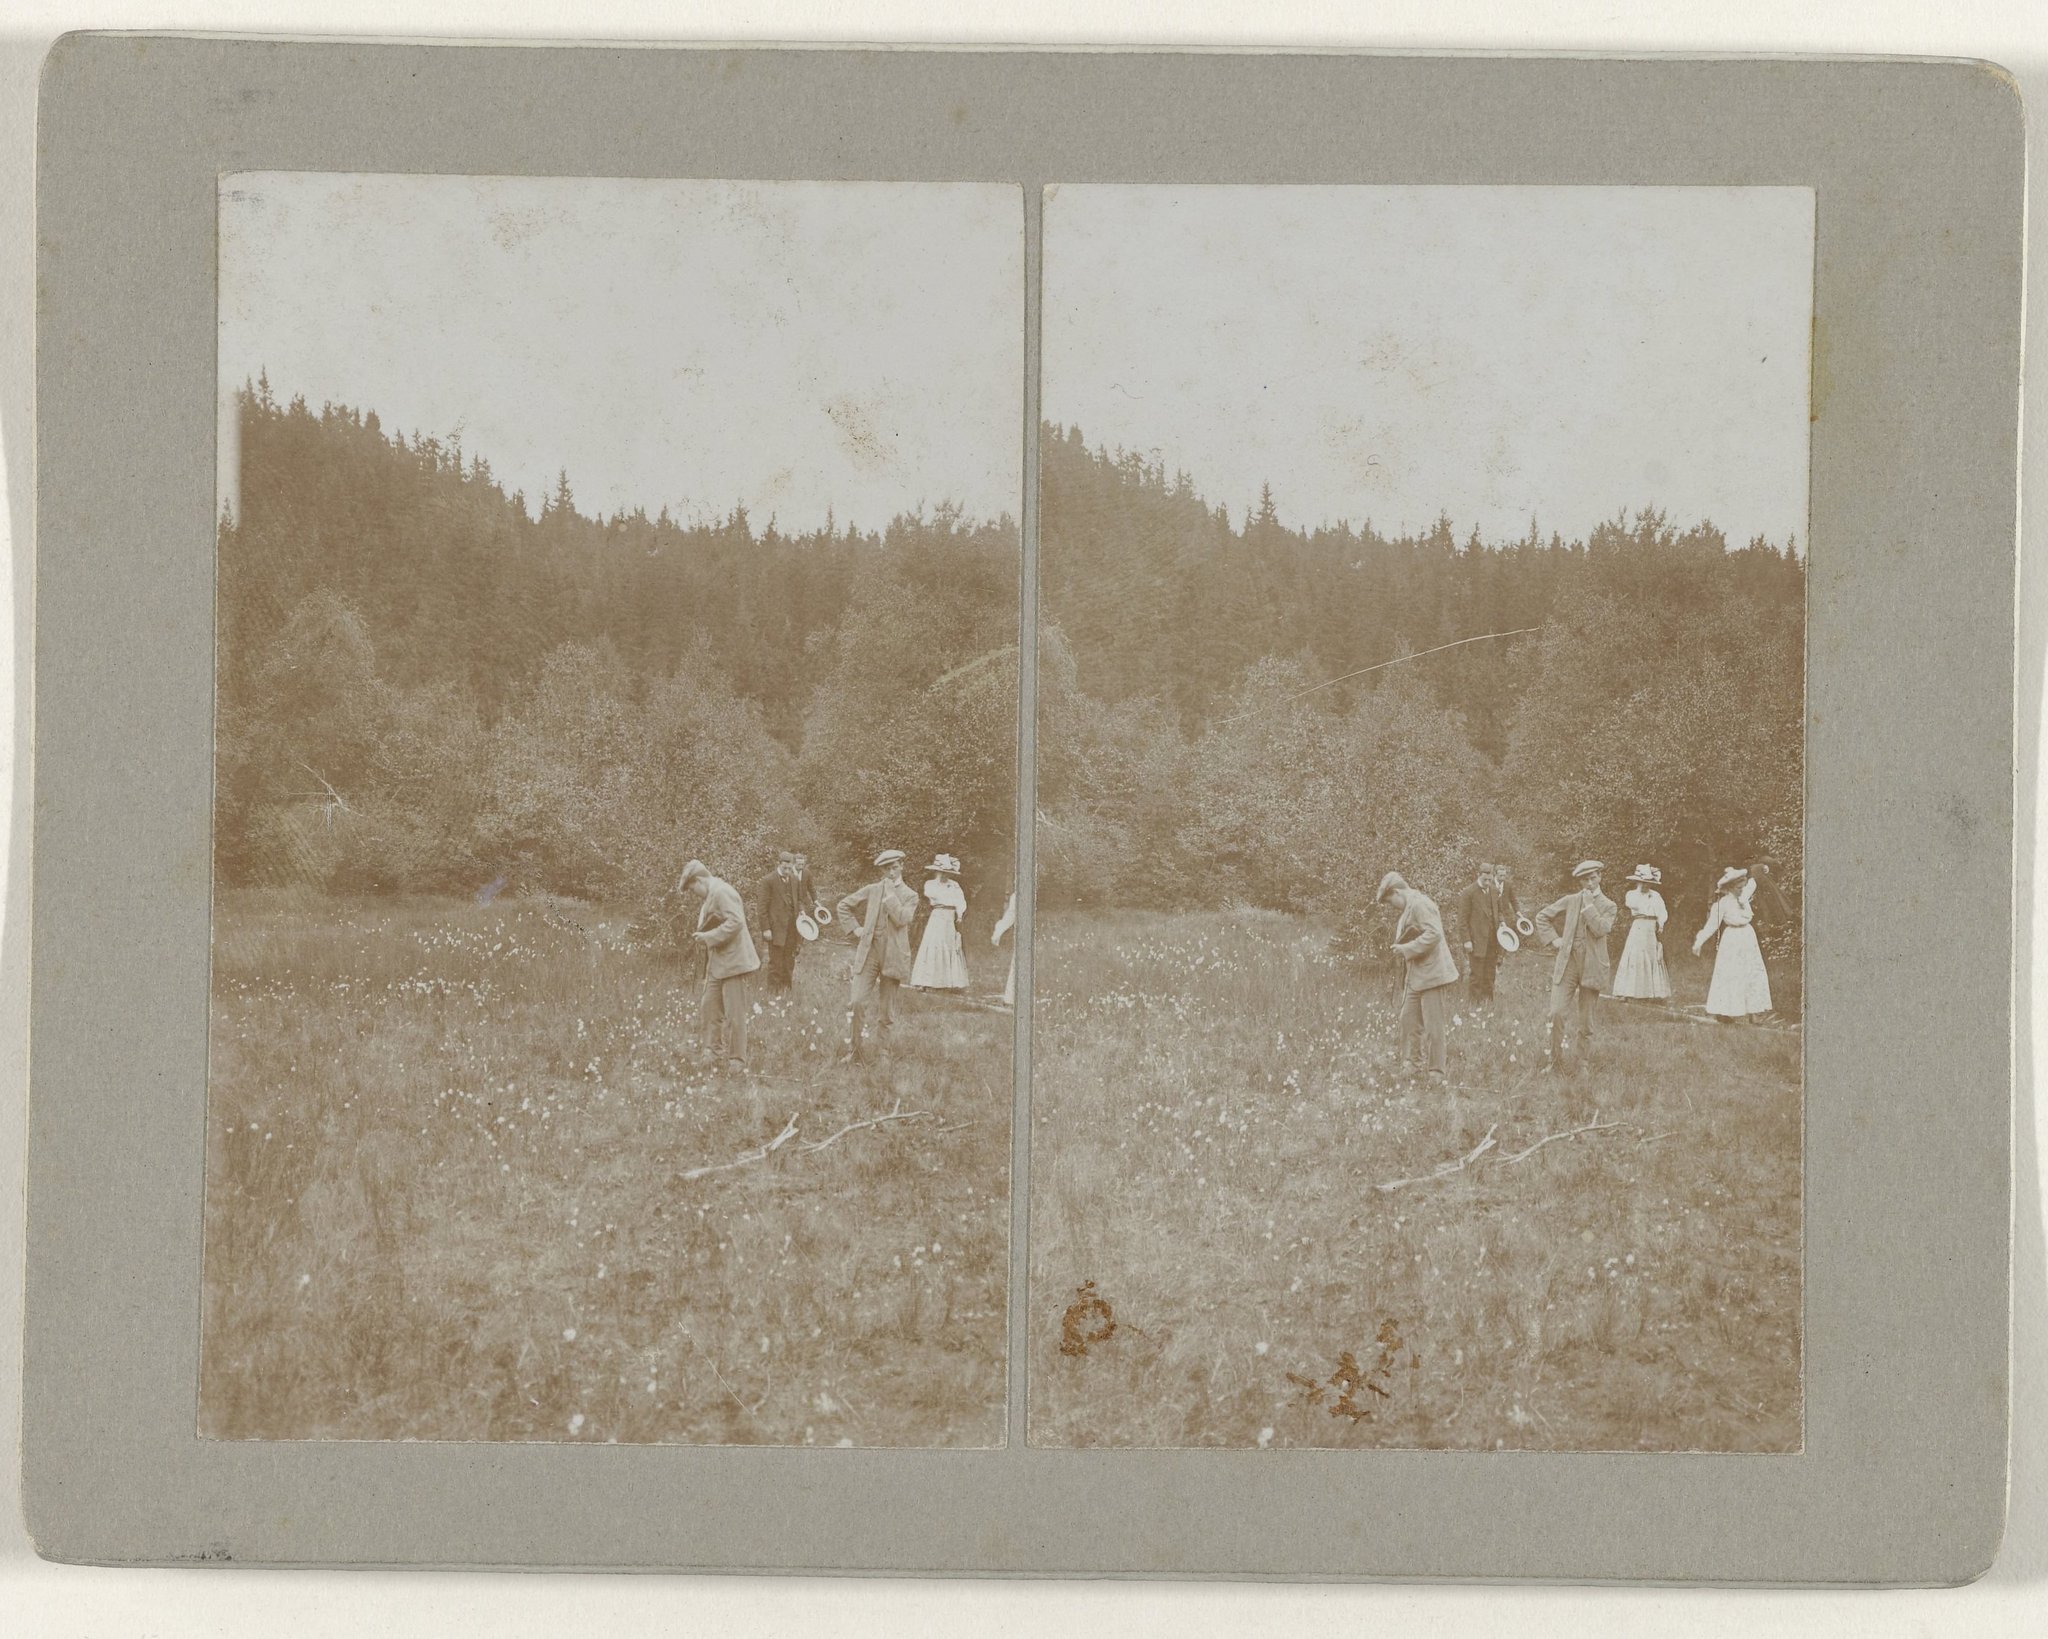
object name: stereograph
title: Wandeling in de bergen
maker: geldolph adriaan kessler (dolph)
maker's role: fotograaf, industrieel, voetballer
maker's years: 1884-1945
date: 1909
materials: paper, photographic support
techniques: collodion silver print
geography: austria